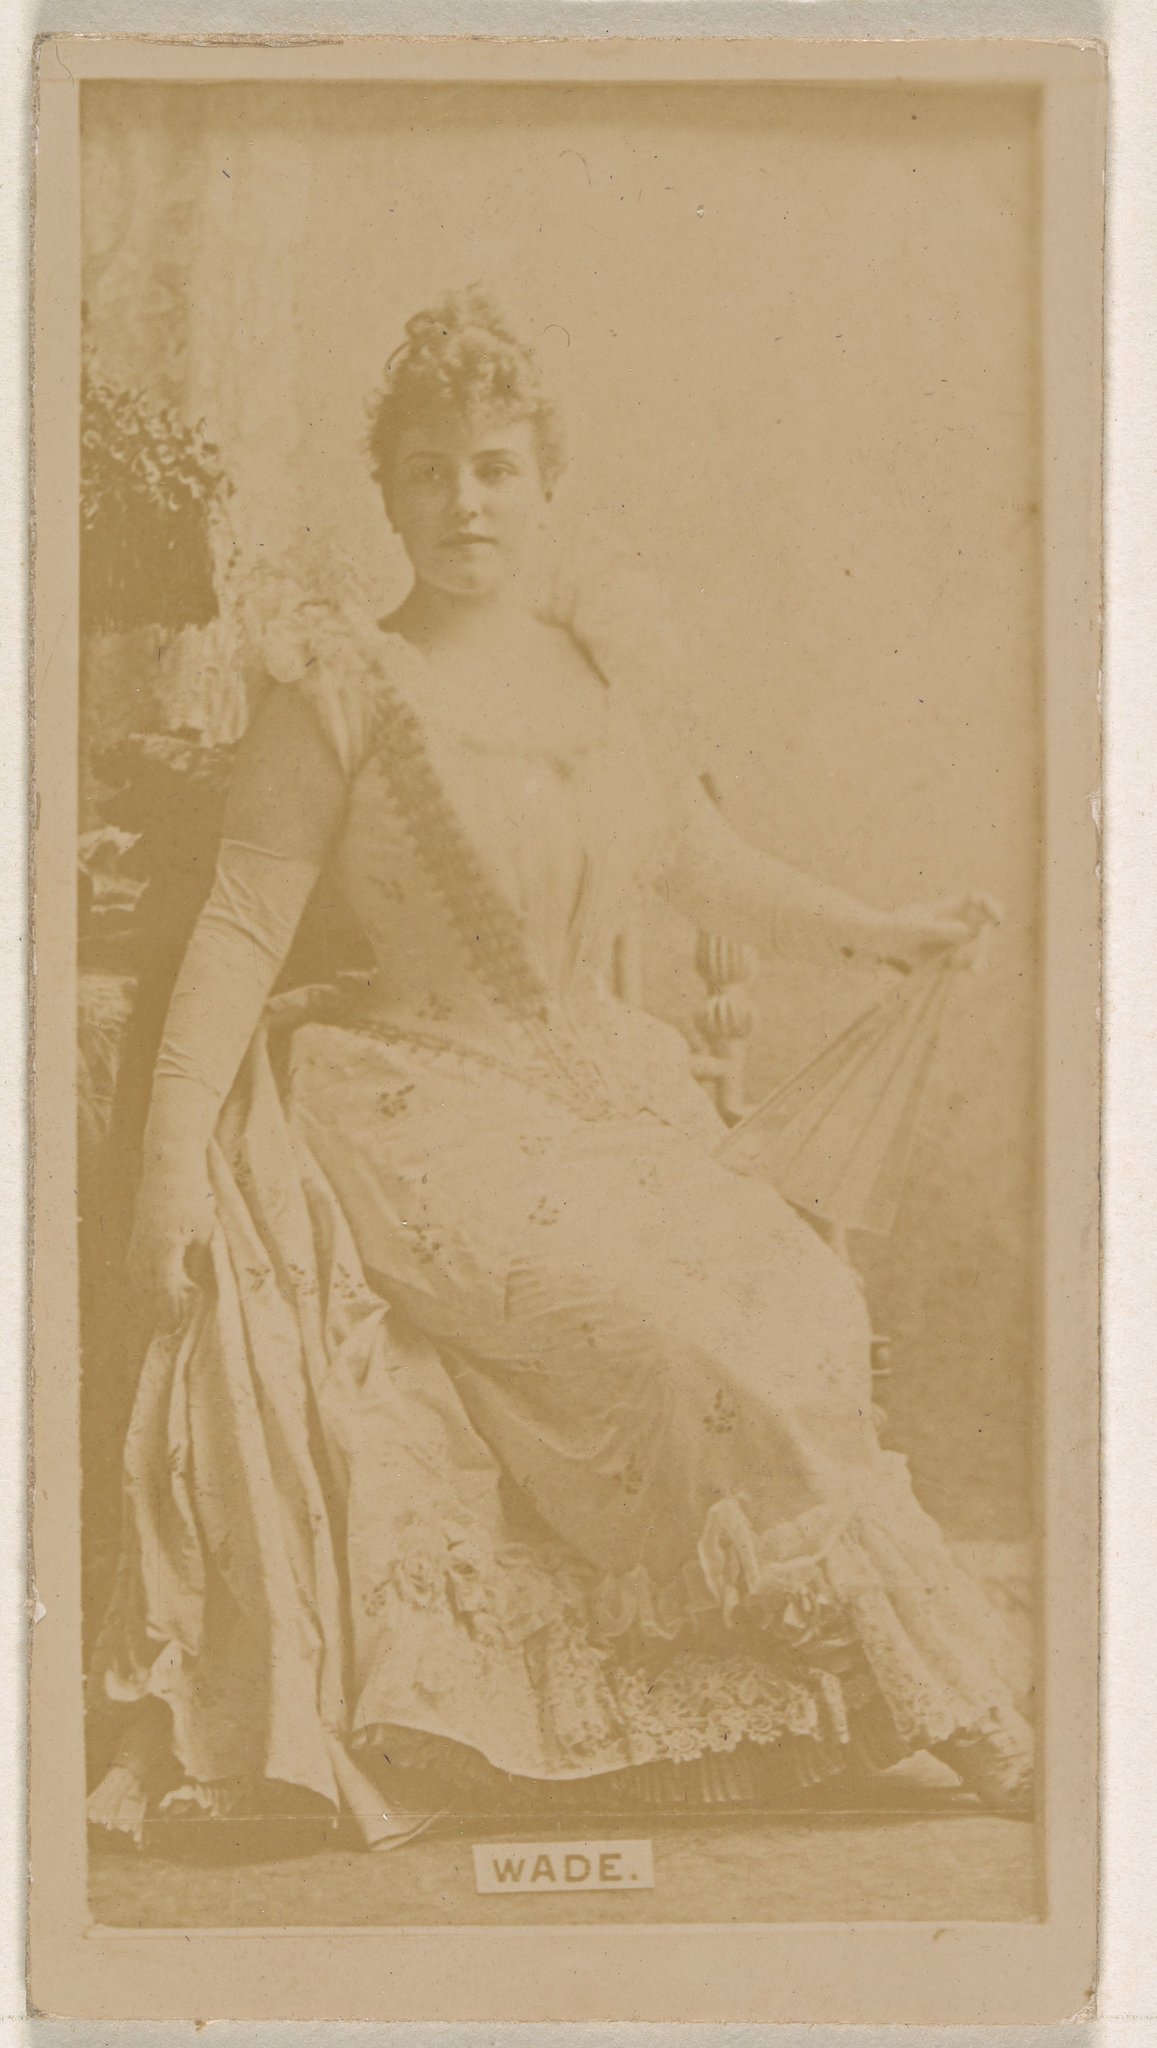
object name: photograph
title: Miss Wade, from the Actresses series (N245) issued by Kinney Brothers to promote Sweet Caporal Cigarettes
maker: kinney brothers tobacco company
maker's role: publisher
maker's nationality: american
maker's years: 1869-2011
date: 1890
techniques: albumen silver print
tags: portraits,women,actresses